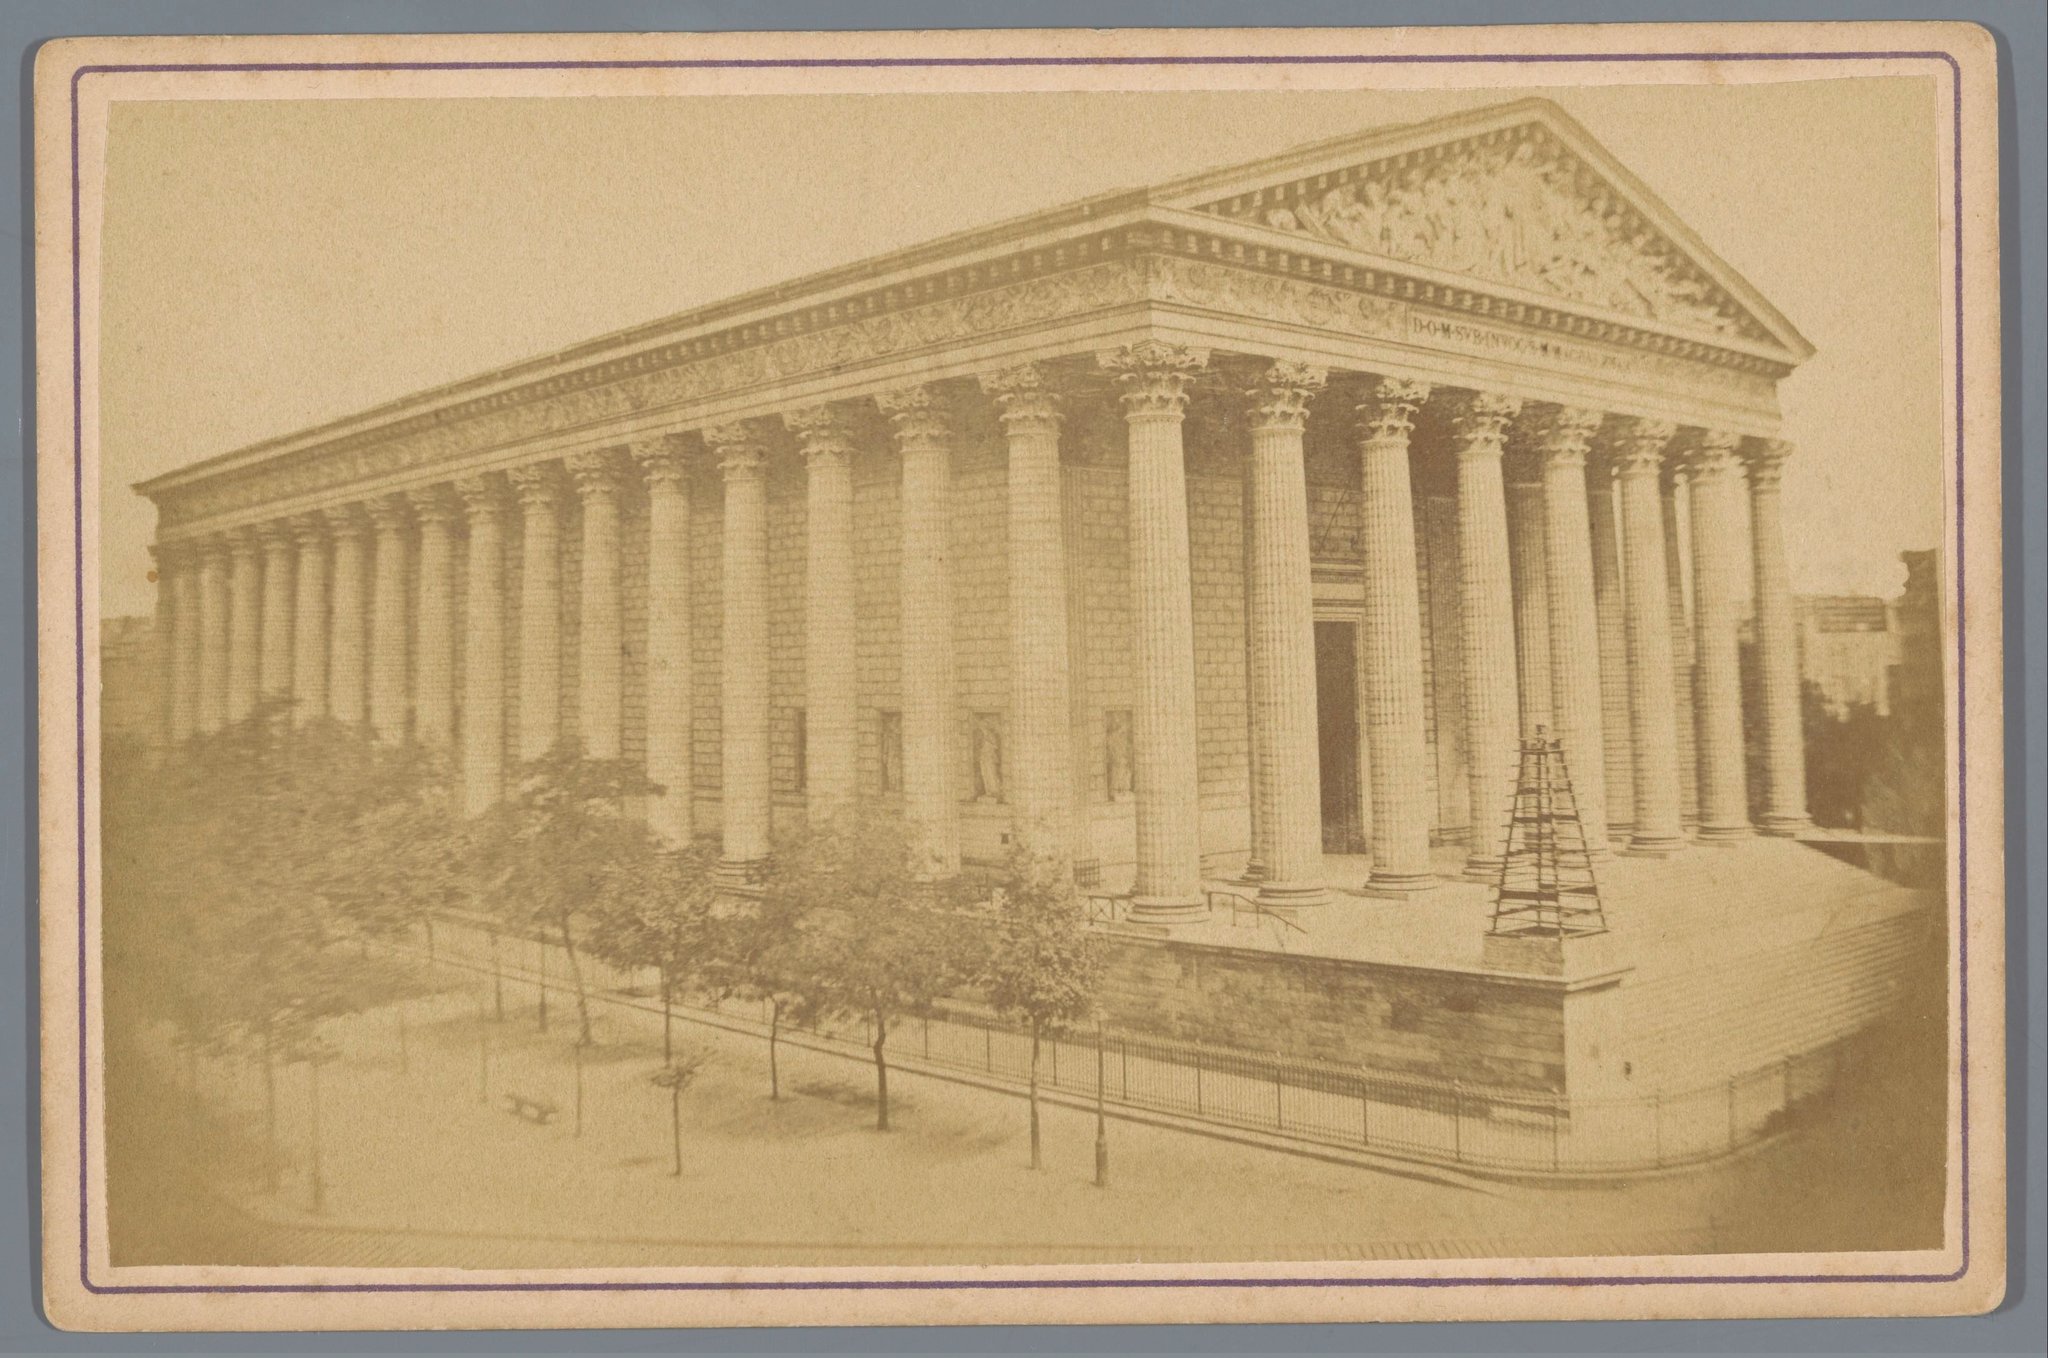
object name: cabinet photograph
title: Exterieur van La Madeleine te Parijs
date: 1865-1875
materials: cardboard, photographic support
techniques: albumen print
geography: paris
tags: church (exterior), façade (of house or building)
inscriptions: inscription: ‘Compagnie Photographique Debitte & Hervé 170, Rue de Rivoli, Paris’, inscription: ‘La Madeleine’